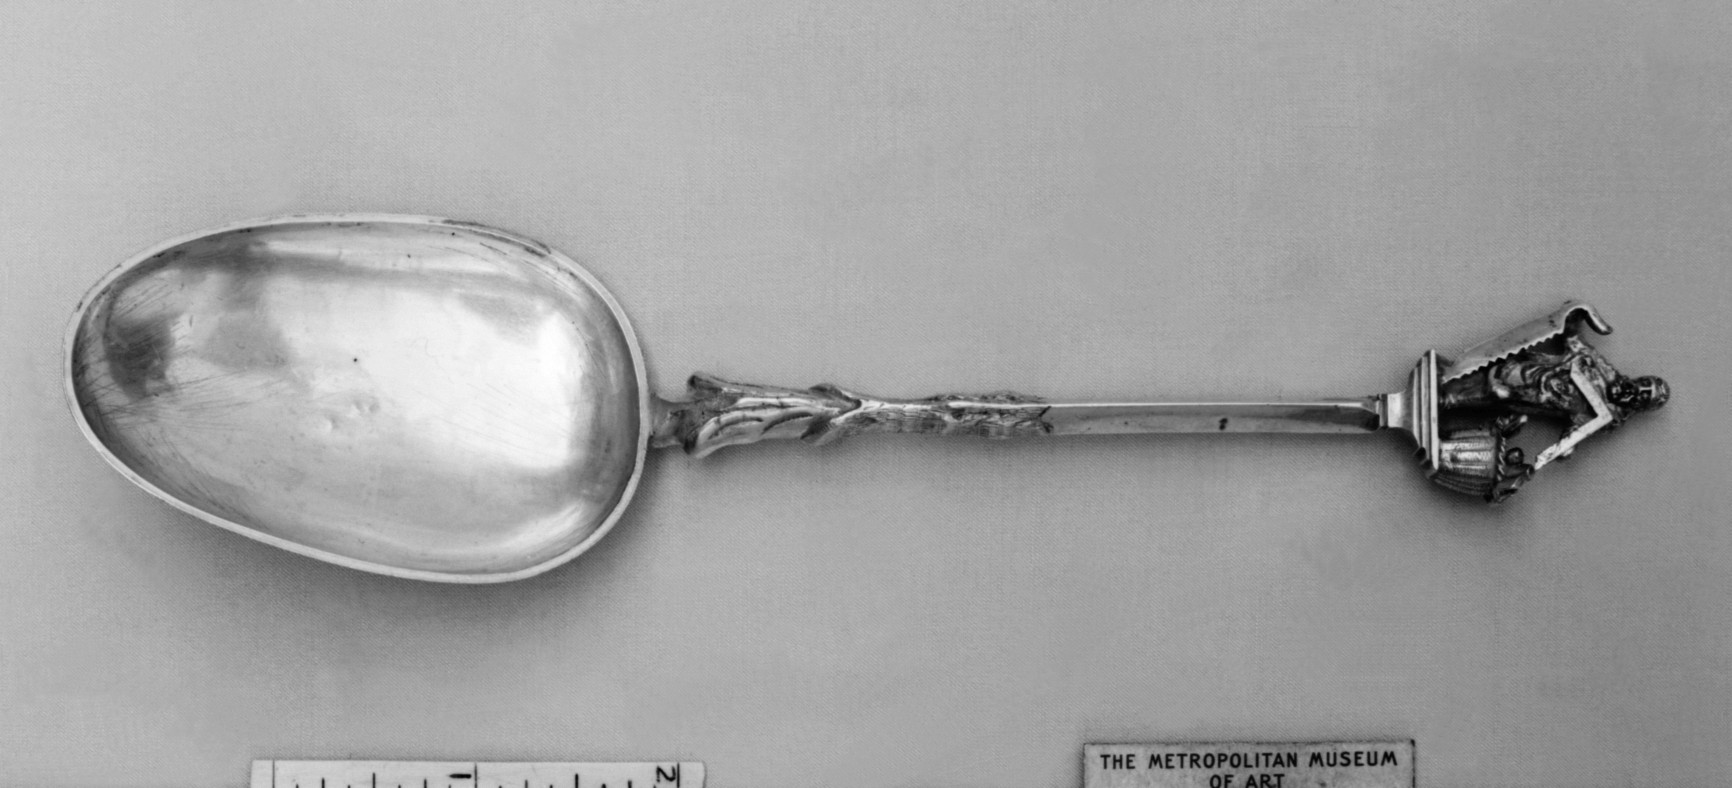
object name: spoon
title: Figure-top spoon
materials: silver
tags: men